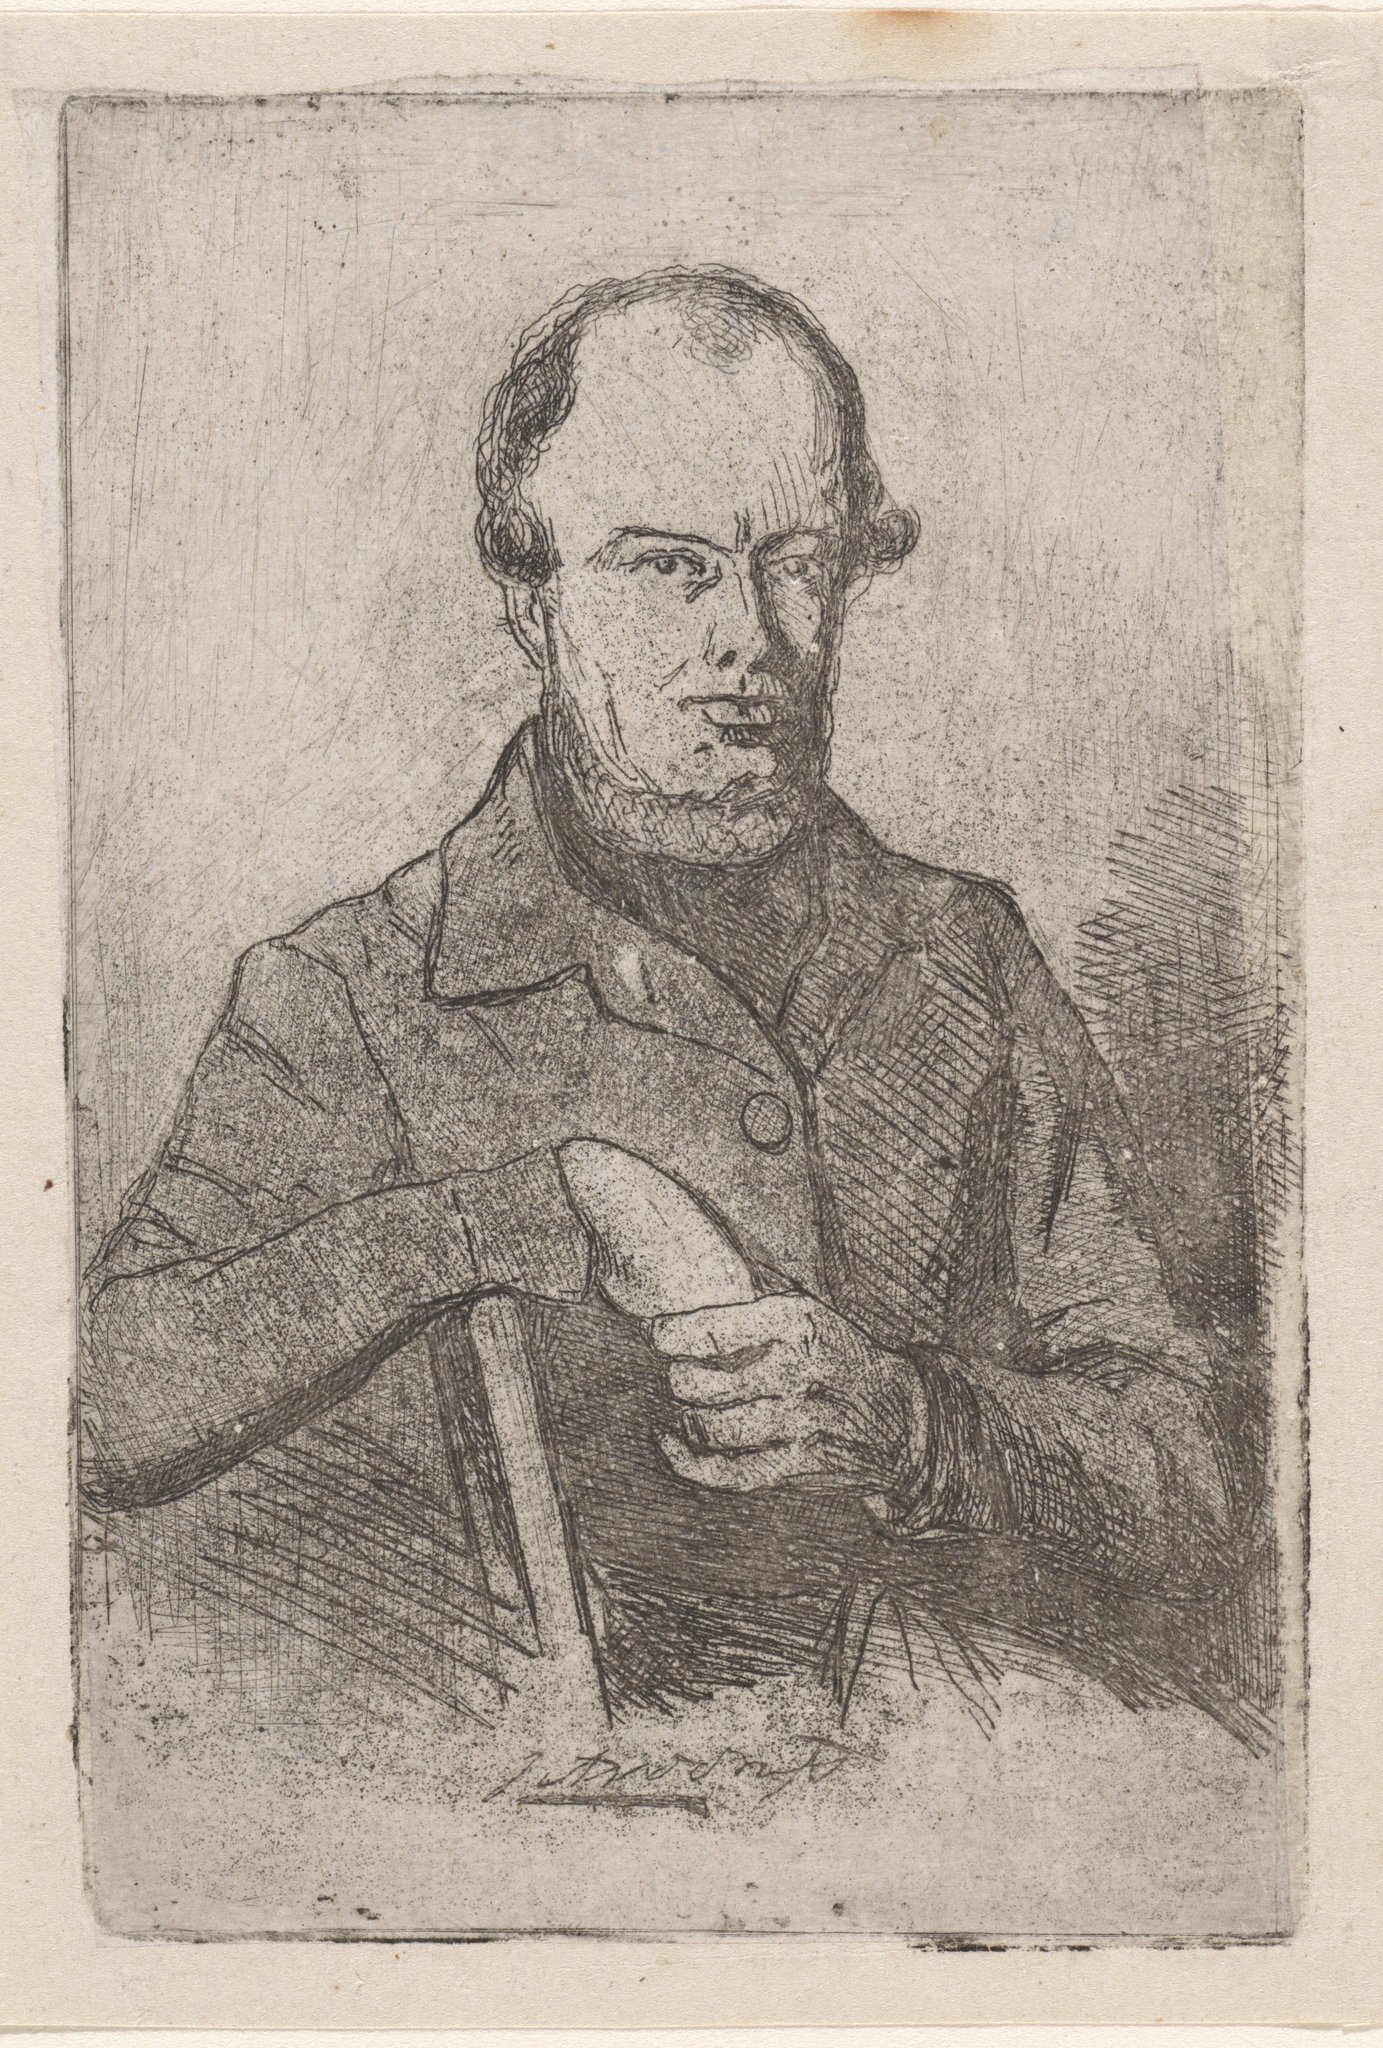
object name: print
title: Portret van Johannes Adrianus van der Drift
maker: jan weissenbruch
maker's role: painter, print maker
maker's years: 1822-1880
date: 1850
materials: paper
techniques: etching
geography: the hague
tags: johannes adrianus van der drift, historical persons, portrait, self-portrait of artist, chair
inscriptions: collector's mark: Lugt 2228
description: Portret van Johannes Adrianus van der Drift, kunstenaar. Hij zit op een stoel. Midden onder is de naam van de geportretteerde weergegeven.